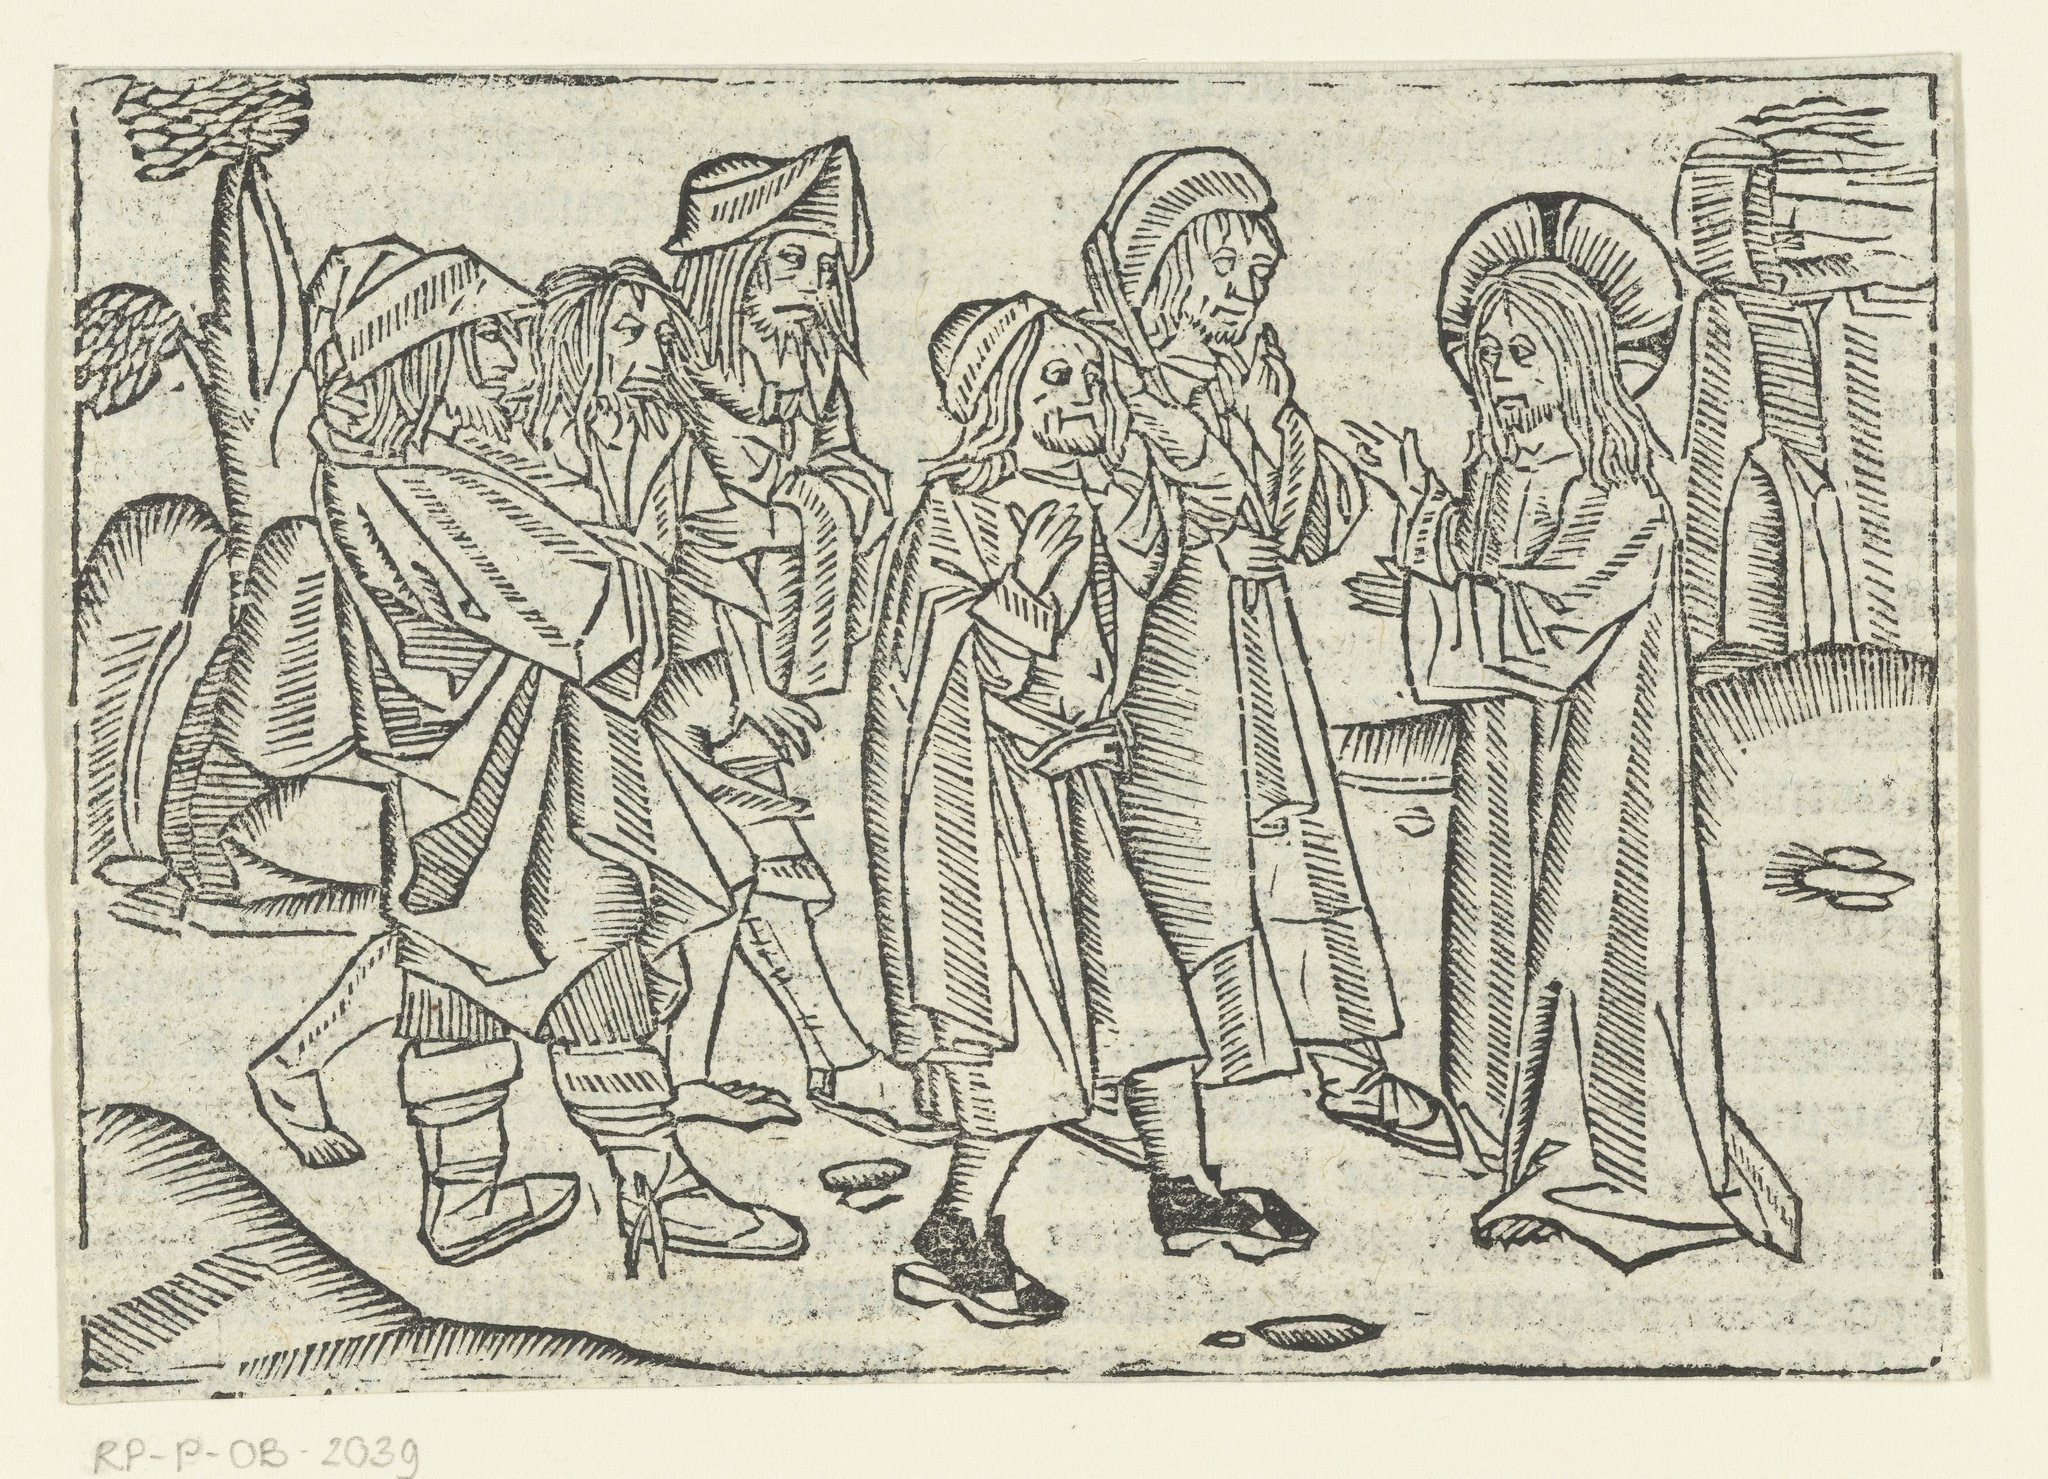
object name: print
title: Christus geneest twee blinden en een doofstomme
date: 1480-1500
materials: paper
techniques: woodcut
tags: healing of a possessed man who could not speak (matthew 9:32-34; luke 11:14-16), healing of two blind men who followed christ into a house (matthew 9:27-31)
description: Christus met twee blinden en een bezeten man, die wordt vastgehouden door twee andere mannen. De voorstelling is gebaseerd op Matteüs 9:32-34 en Lucas 11:14-16. In de Statenvertaling staat het als volgt beschreven: “Als dezen nu uitgingen, ziet, zo brachten zij tot Hem een mens, die stom en van den duivel bezeten was. En als de duivel uitgeworpen was, sprak de stomme.” In de Nieuwe Bijbelvertaling 21 staat: “Terwijl ze het huis weer verlieten, bracht men iemand bij Hem die bezeten was en niet kon spreken. Nadat de demon was uitgedreven, begon de stomme te spreken.”